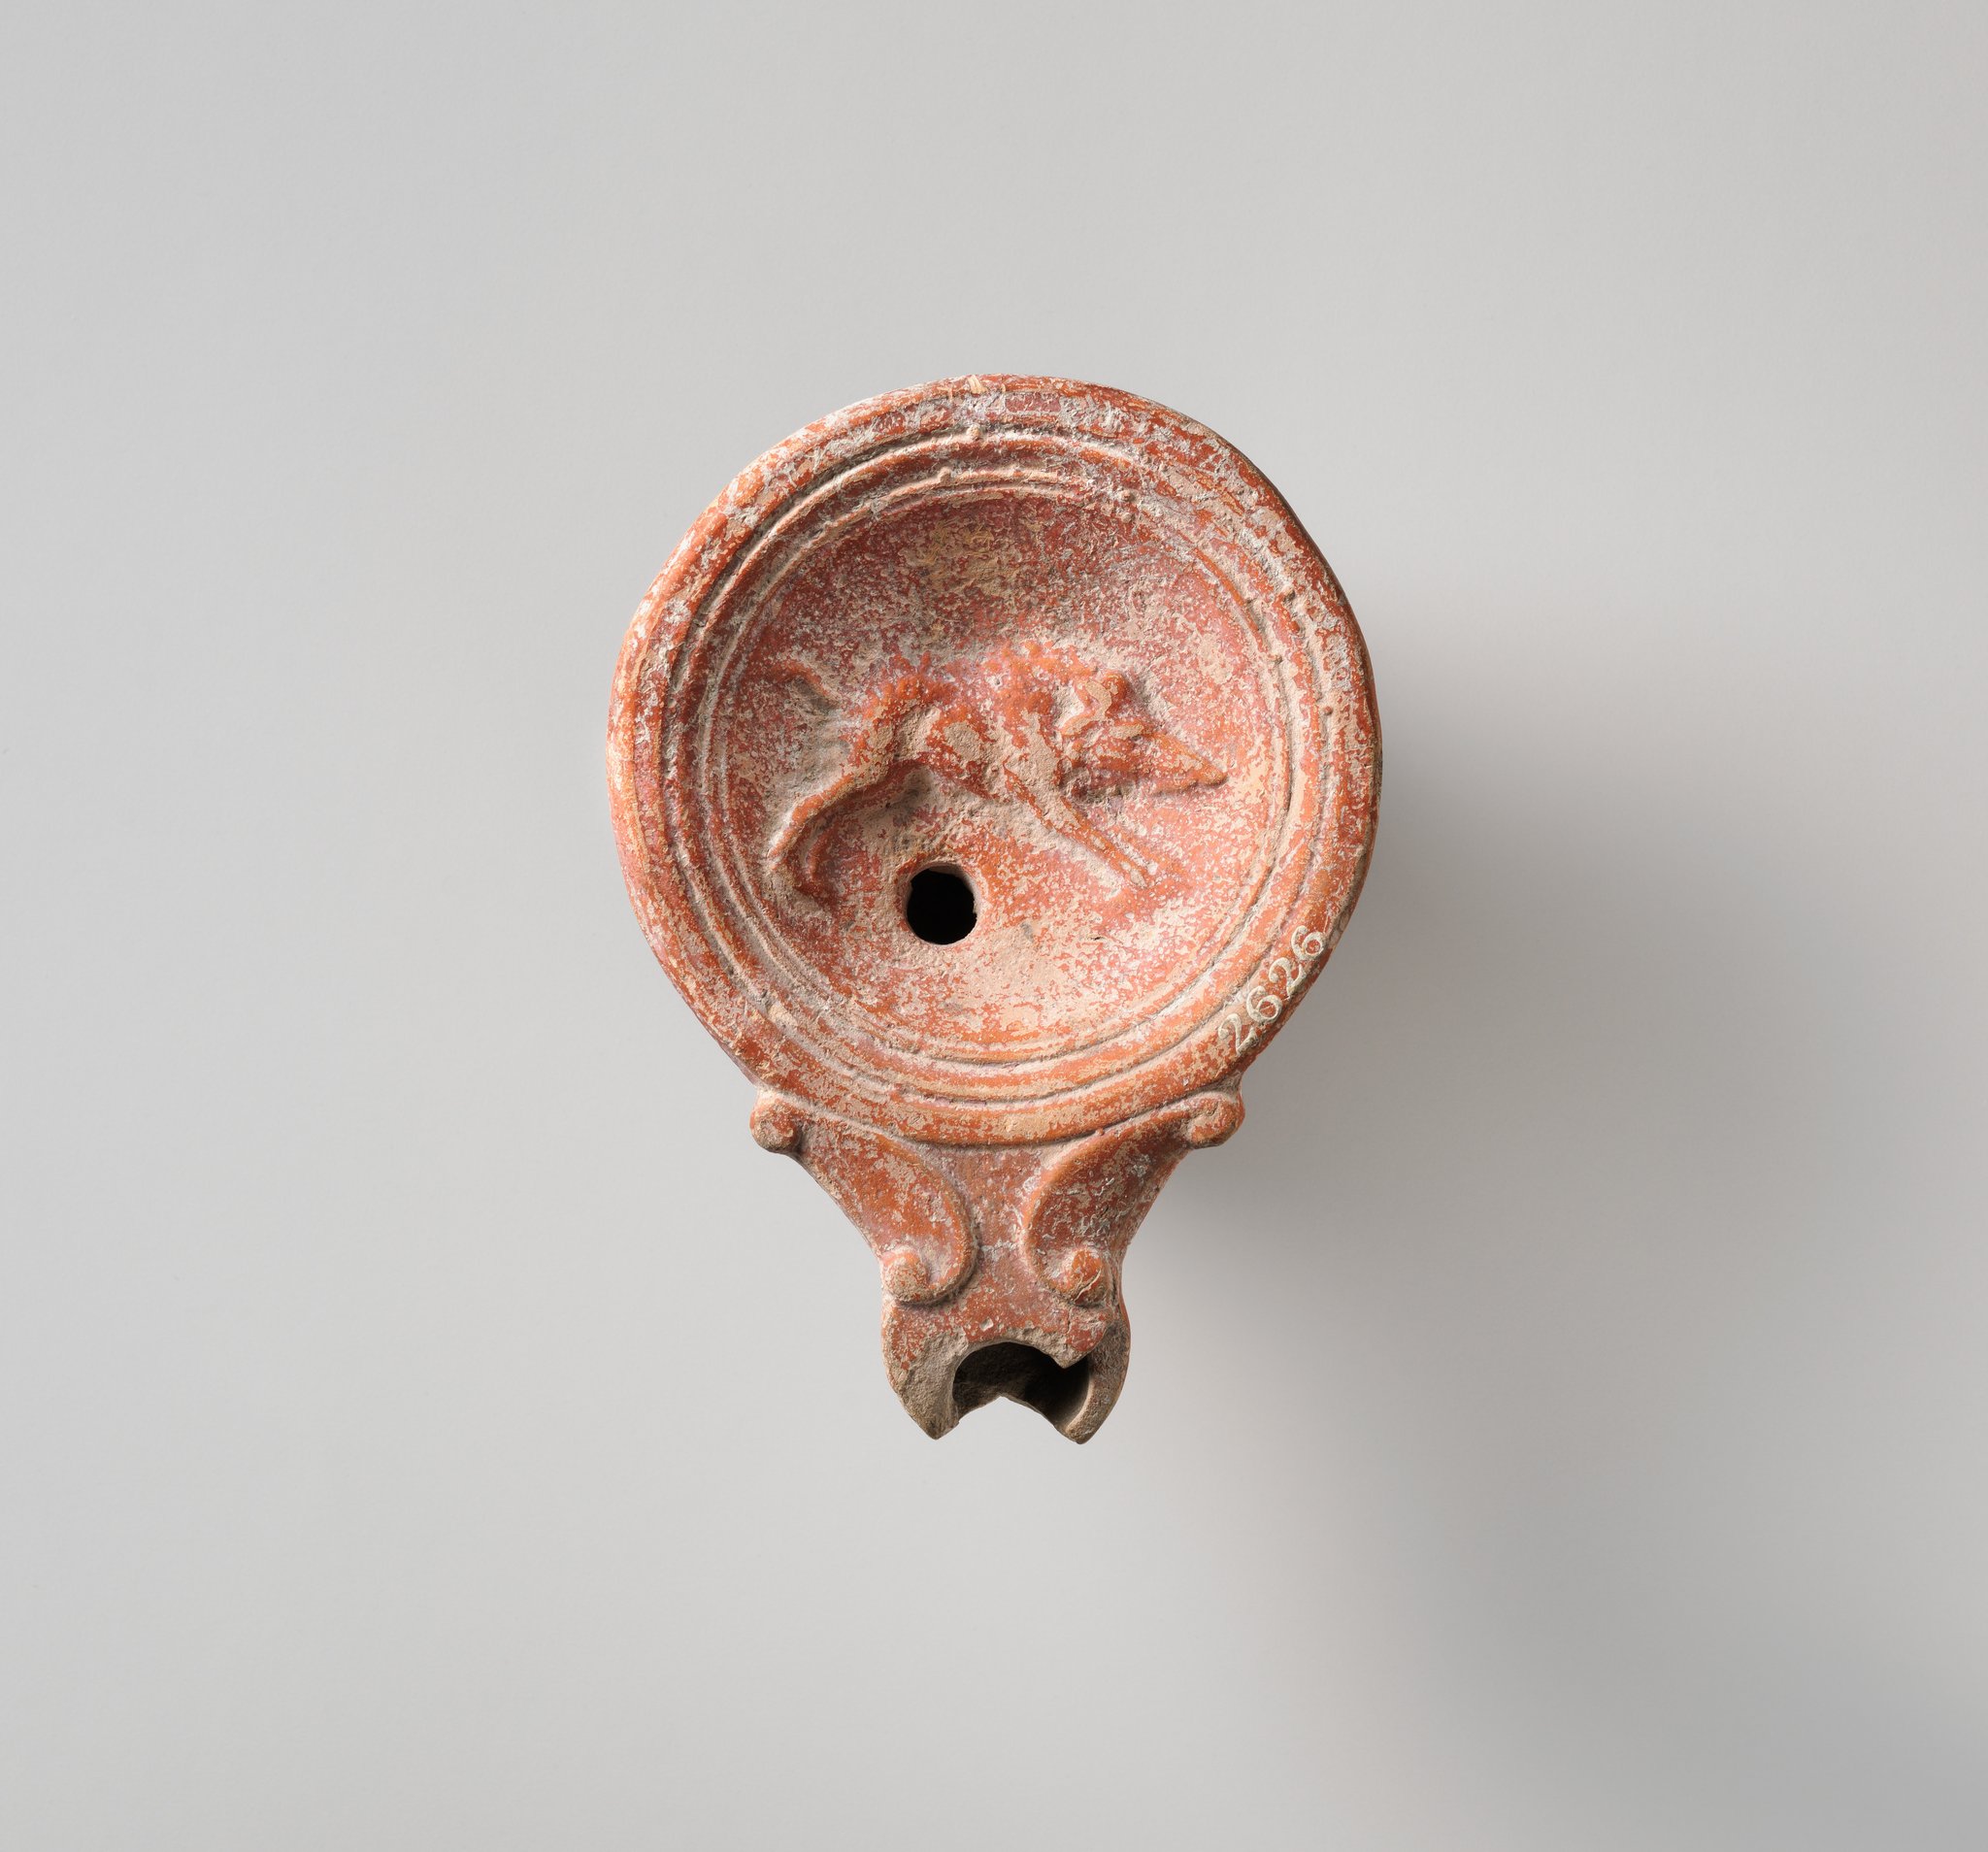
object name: lamp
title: Terracotta oil lamp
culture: roman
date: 1-100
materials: terracotta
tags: boars